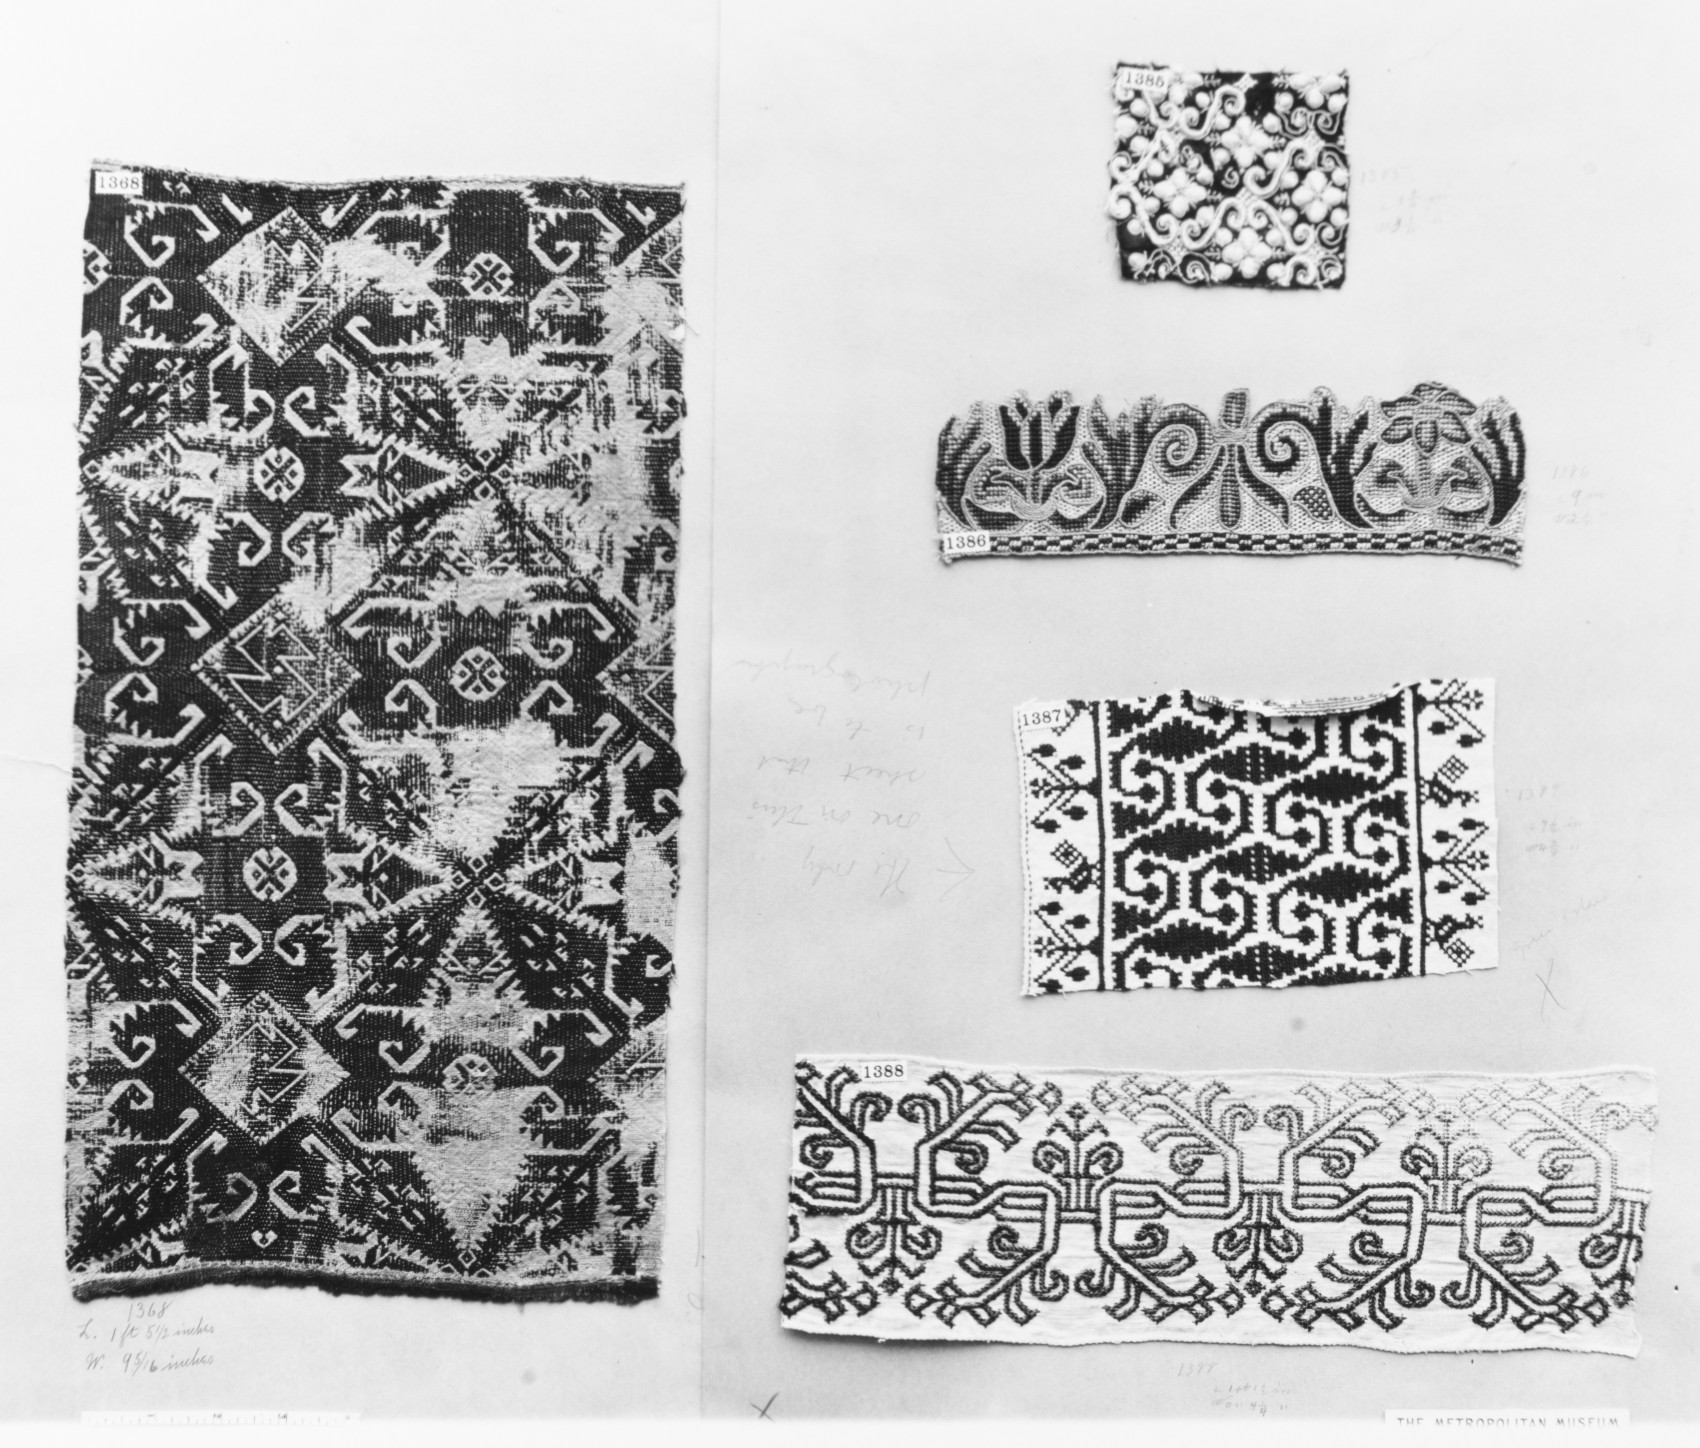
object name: fragment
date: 1601-1700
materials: silk